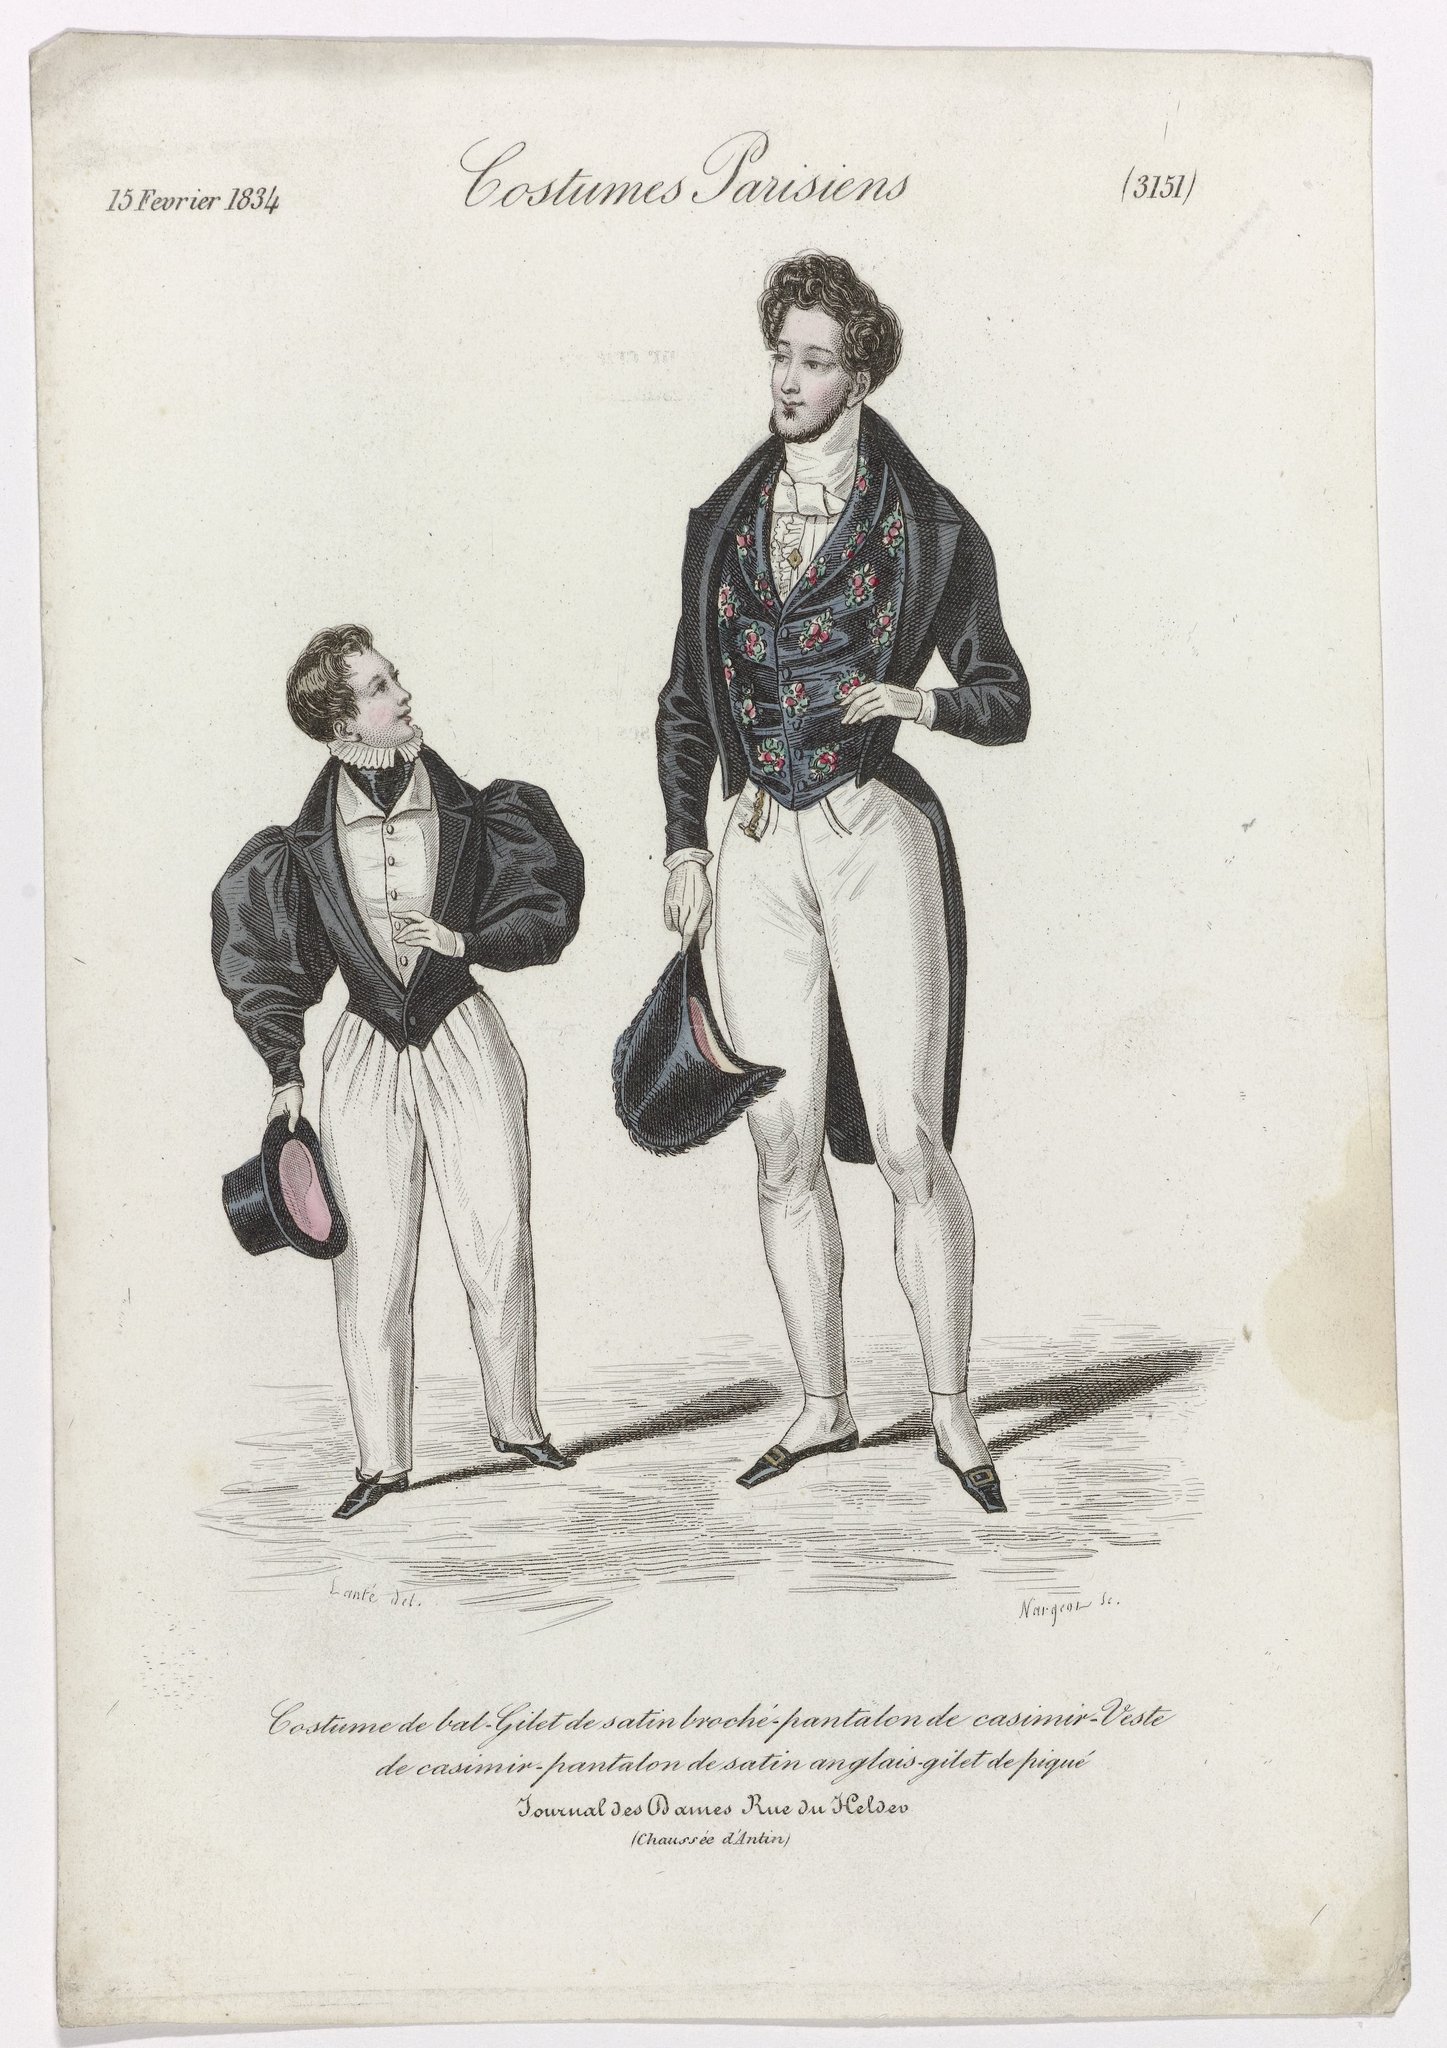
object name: fashion print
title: Journal des Dames et des Modes, Costumes Parisiens, 15 fevrier 1834, (3151): Costume de bal (...)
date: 1832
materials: paper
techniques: engraving, hand coloring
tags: clothing for the upper part of the body (vest) (+ men's clothes), trousers, breeches (+ boys' clothes), clothing for the upper part of the body (vest) (+ boys' clothes), neck-gear ~ clothing (shawl collar) (+ men's clothes), trousers, breeches, etc. (pantalon) (+ men's clothes), shoes, sandals (+ boys' clothes), party clothes, festive attire (+ men's clothes), coat (+ men's clothes), coat (+ boys' clothes), ensembles of pieces of clothing (dress suit) (+ men's clothes), fashion plates, shoes, sandals (+ men's clothes), gloves, mittens, etc. (+ men's clothes), head-gear: bicorne, bicorn (+ men's clothes)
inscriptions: title: ‘Costumes Parisiens.’, caption: ‘Costumes de bal-Gilet de satin broché-pantalon de casimir. Veste de casimir-pantalon de satin anglais-gilet de piqué’, address: ‘Journal des Dames Rue de Helder / (Chaussée d'Antin)’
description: Man en jongen in balkostuums. De man draagt een vest van gebrocheerd satijn op een lange nauwsluitende broek van 'casimir'. Jas met sjaalkraag. Geknoopte halsdoek en geplooide jabot. Accessoires: dasspeld, handschoenen, tweekantige steek (bicorne) , platte schoenen met vierkante gespen en neuzen. De jongen draagt een jas van 'casimir', vest van piqué en lange broek van 'satin anglais'. Accessoires: hoge hoed, schoenen met vierkante neuzen. De prent maakt deel uit van het modetijdschrift Journal des Dames et des Modes, Parijs, 1797-1839.